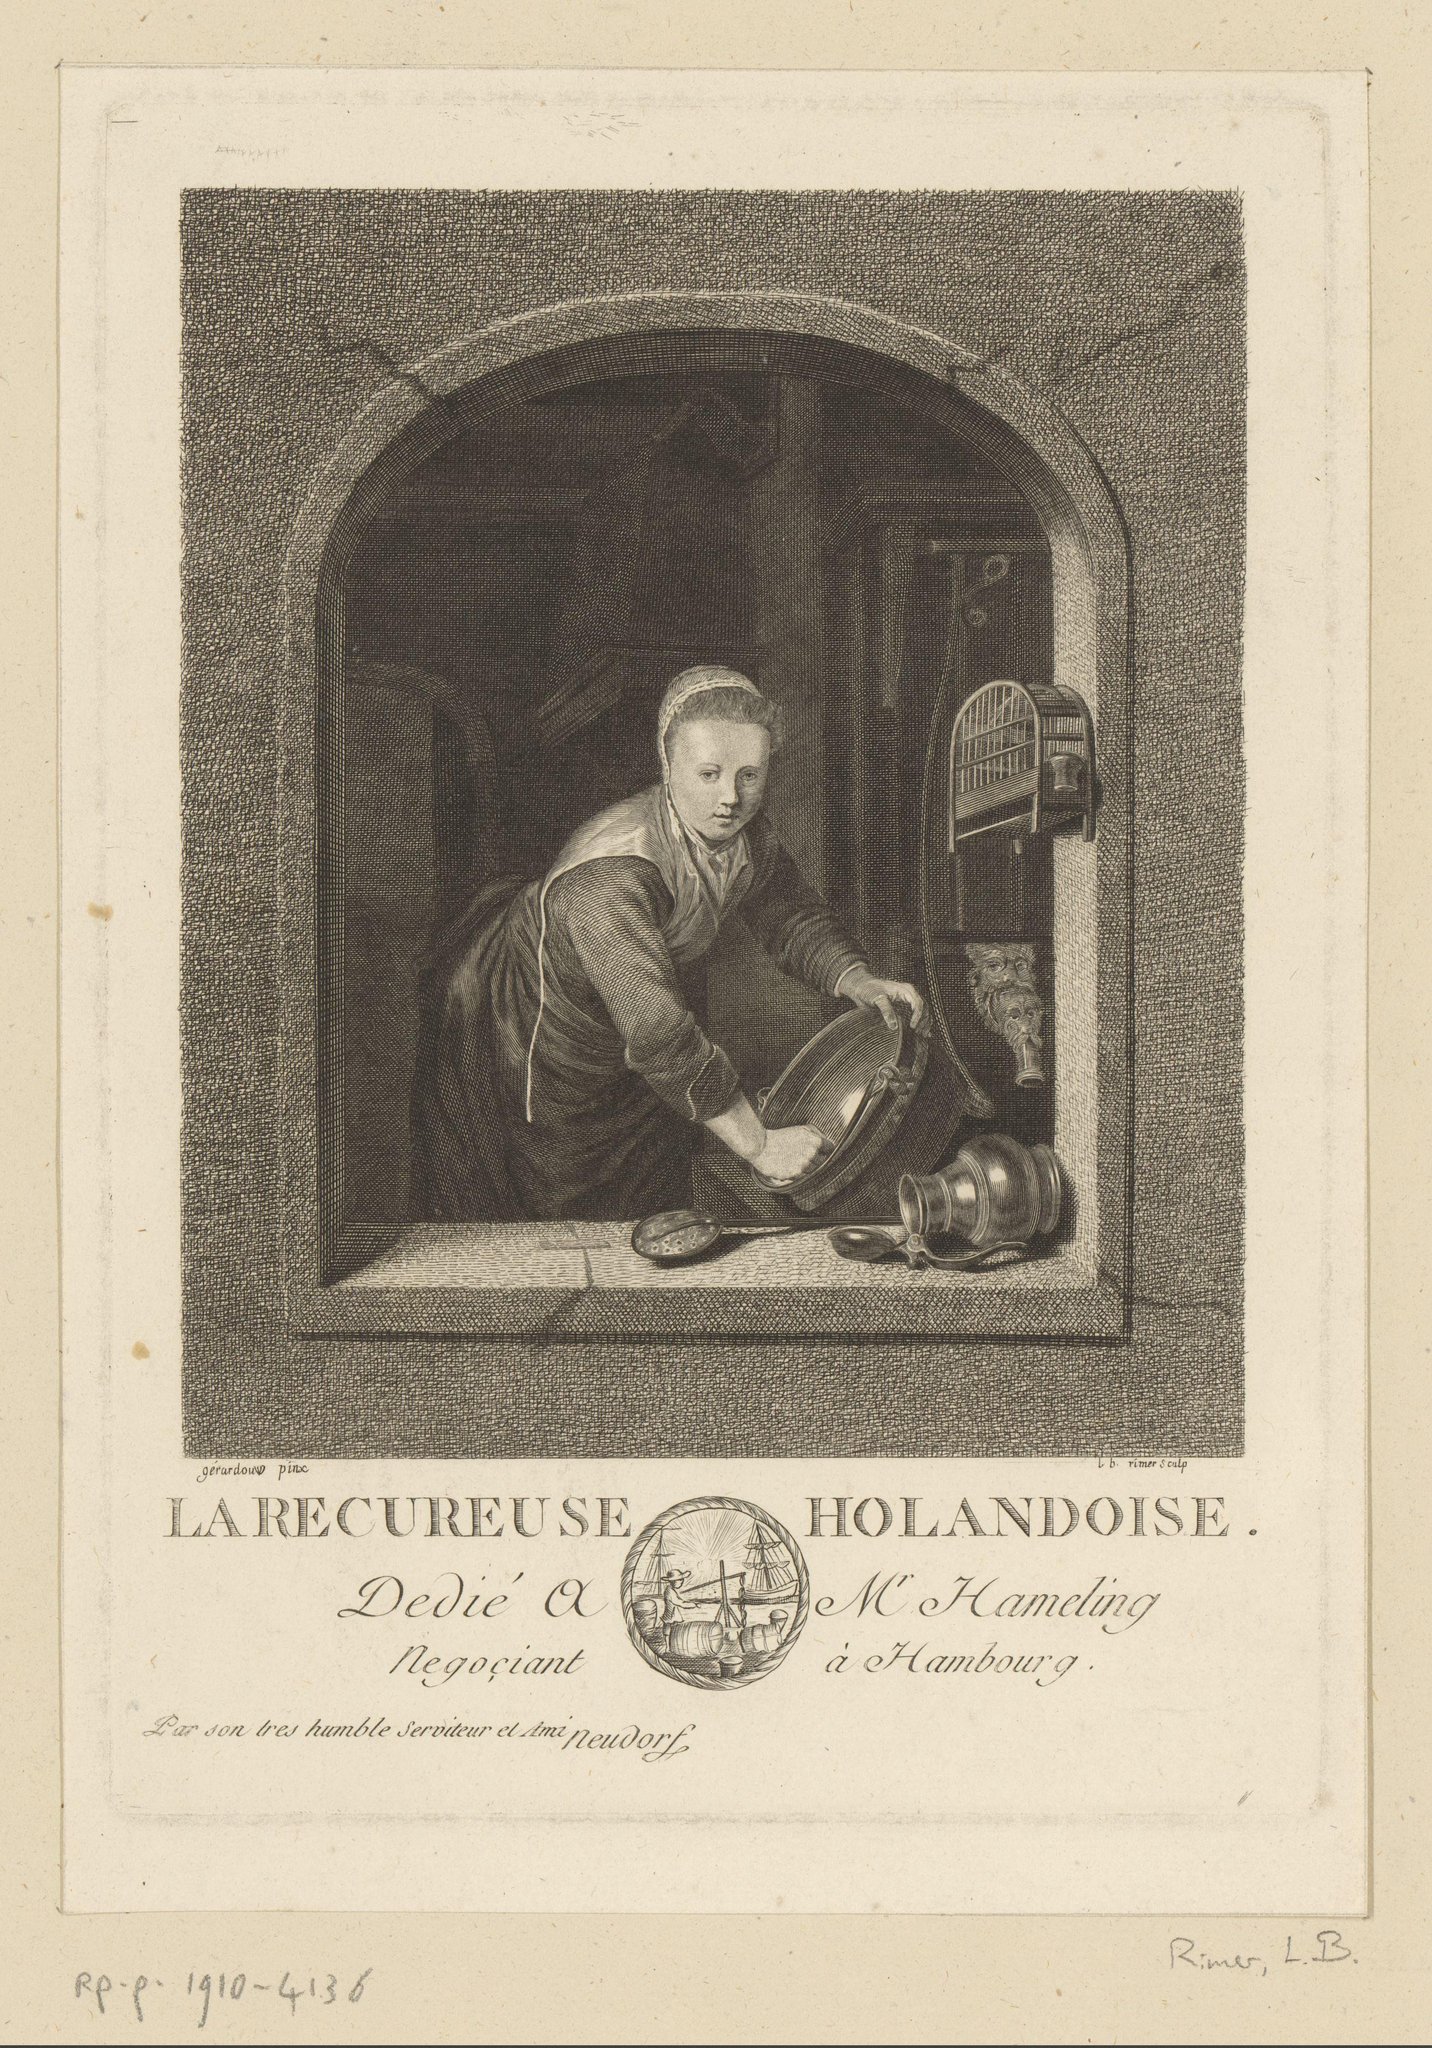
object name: print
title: La recureuse Holandoise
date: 1700-1799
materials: paper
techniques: engraving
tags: empty bird cage, human figure at (open) window, seen from outside, washing up, container of metal: bucket, can, canister, drum, tin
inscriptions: collector's mark: Lugt 2228